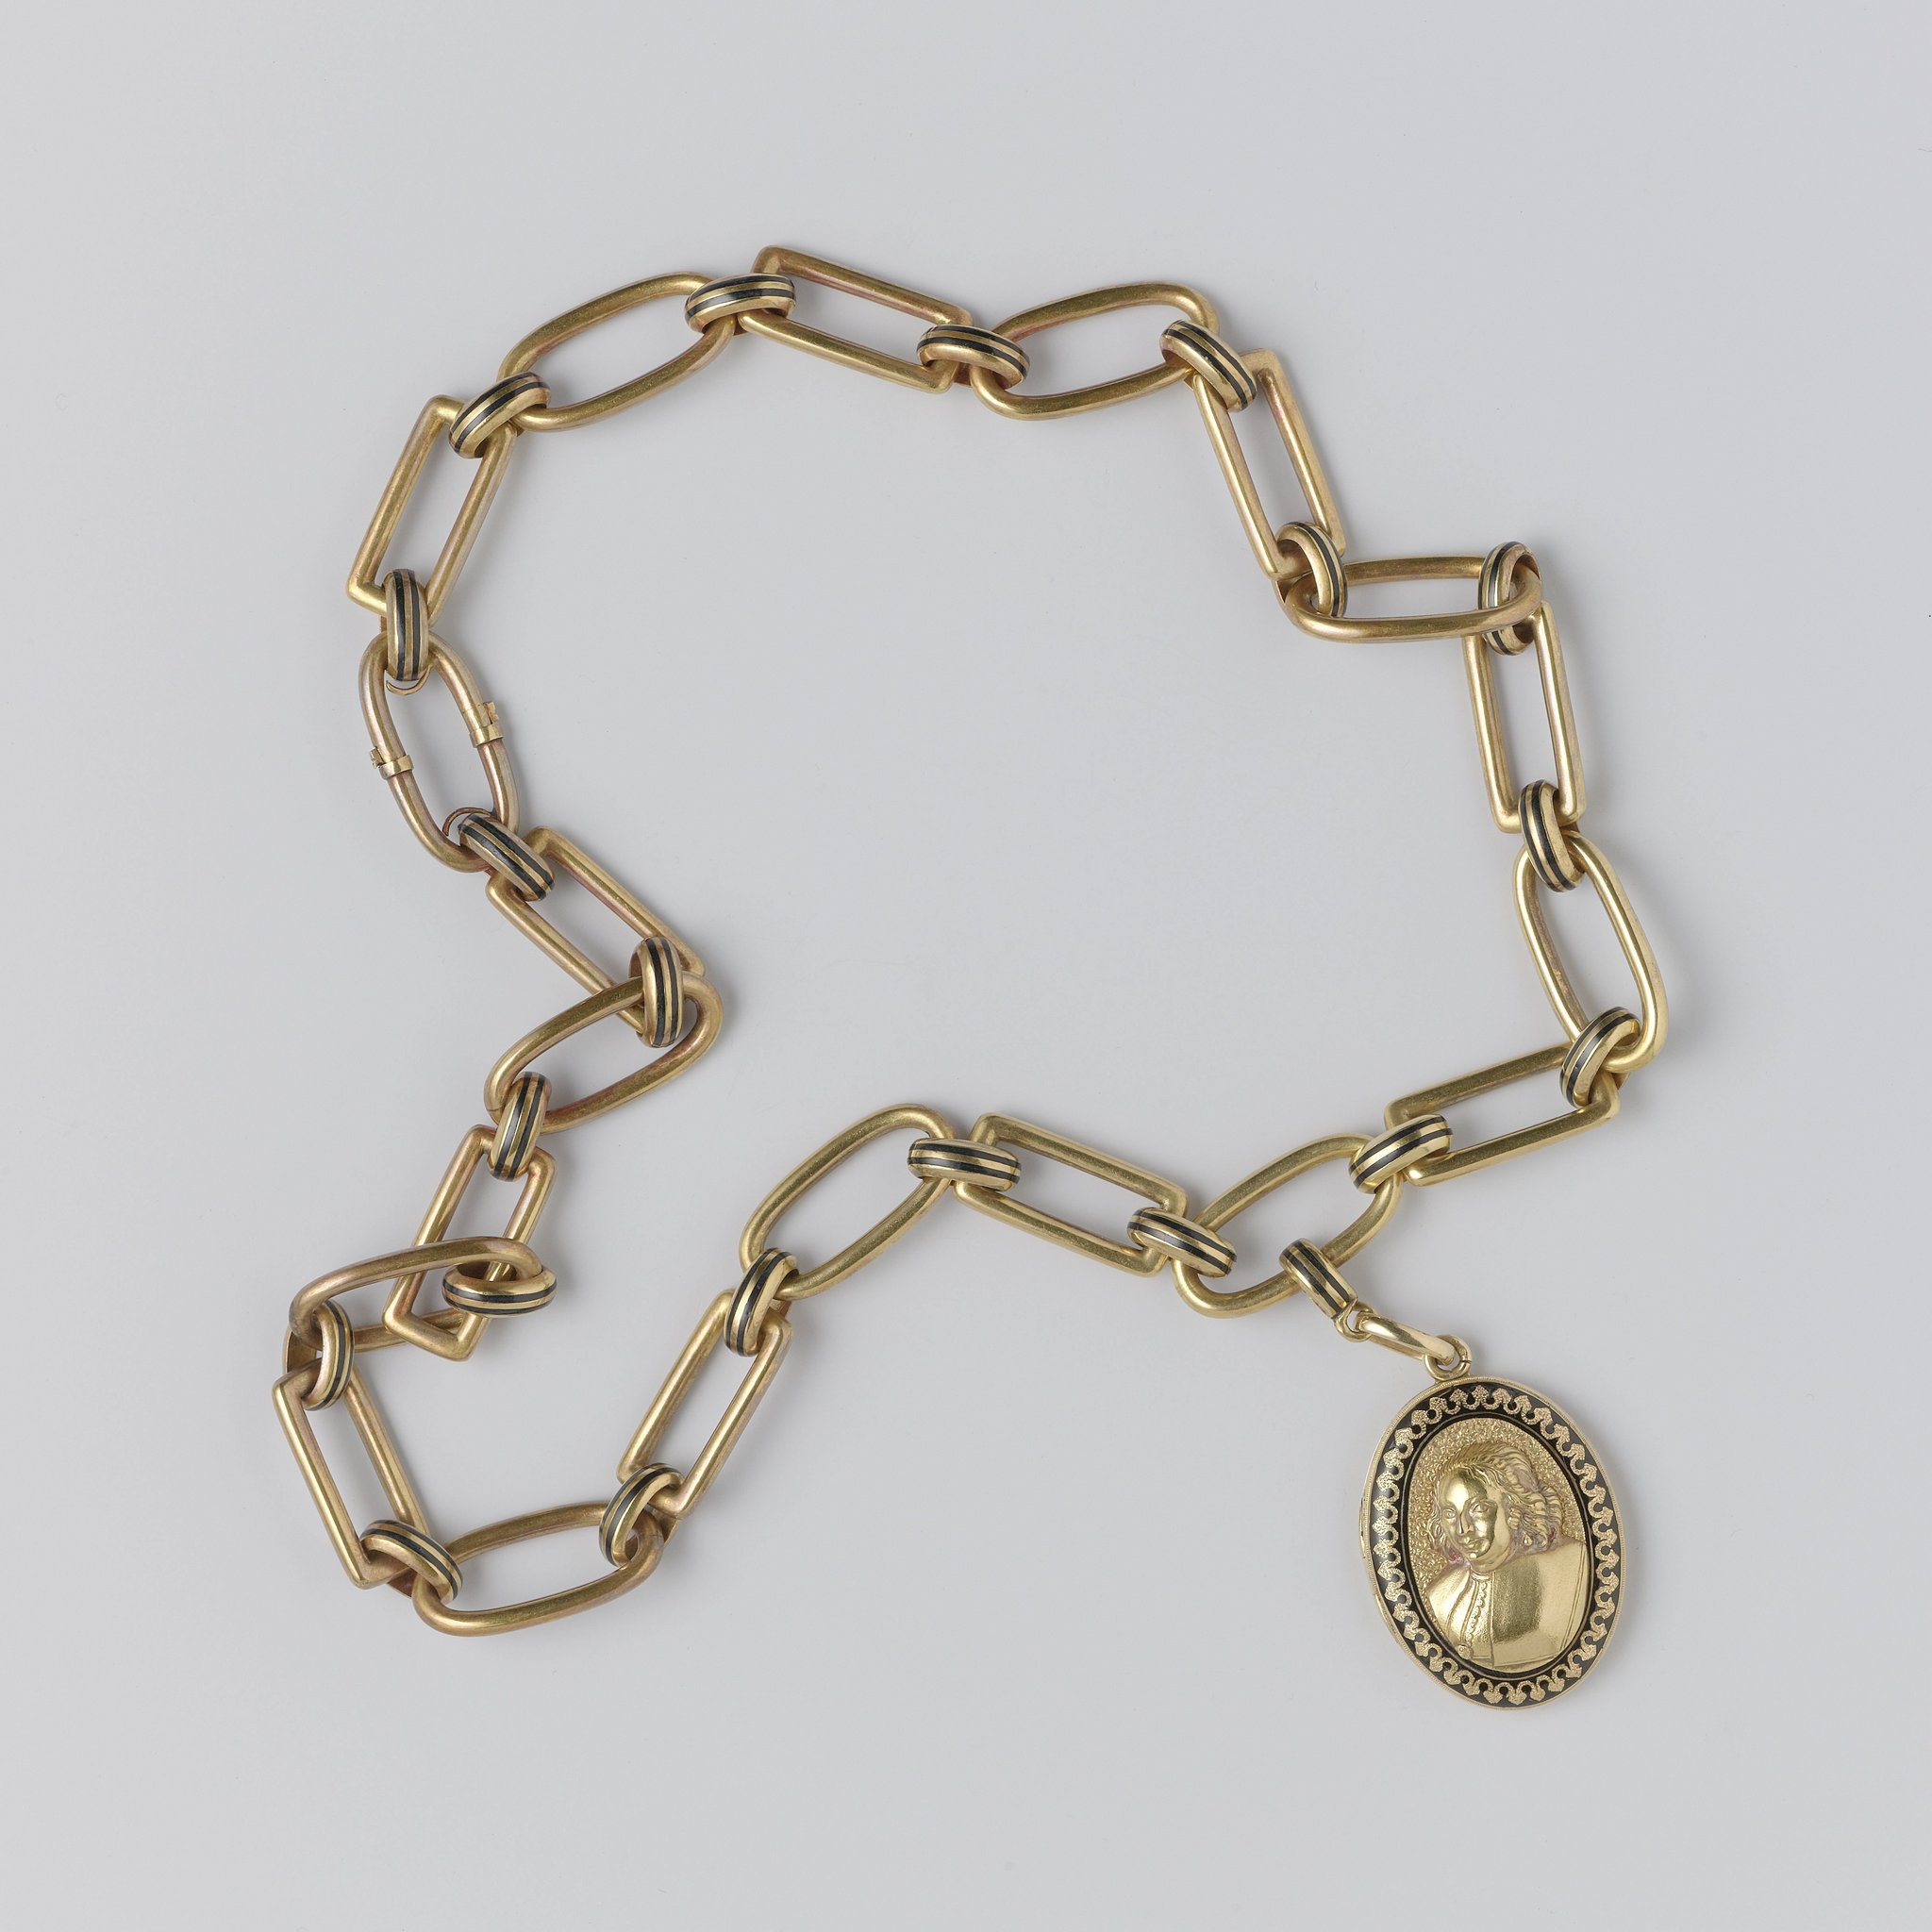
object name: jewellery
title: Parure (set of matching jewellery)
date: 1854-1858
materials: gold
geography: voorschoten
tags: amsterdam, everhardus johannes potgieter, the hague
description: The writer and journalist E.J. Potgieter was among the first in the 19th century to devote attention to women from the past. He commissioned this jewellery set as a gift for a relative. The seven depicted Dutch women symbolize decisiveness and fortitude. Potgieter believed his lethargic countrymen could learn a lesson from them. The medallion contains a photograph of Potgieter and a lock of his hair.